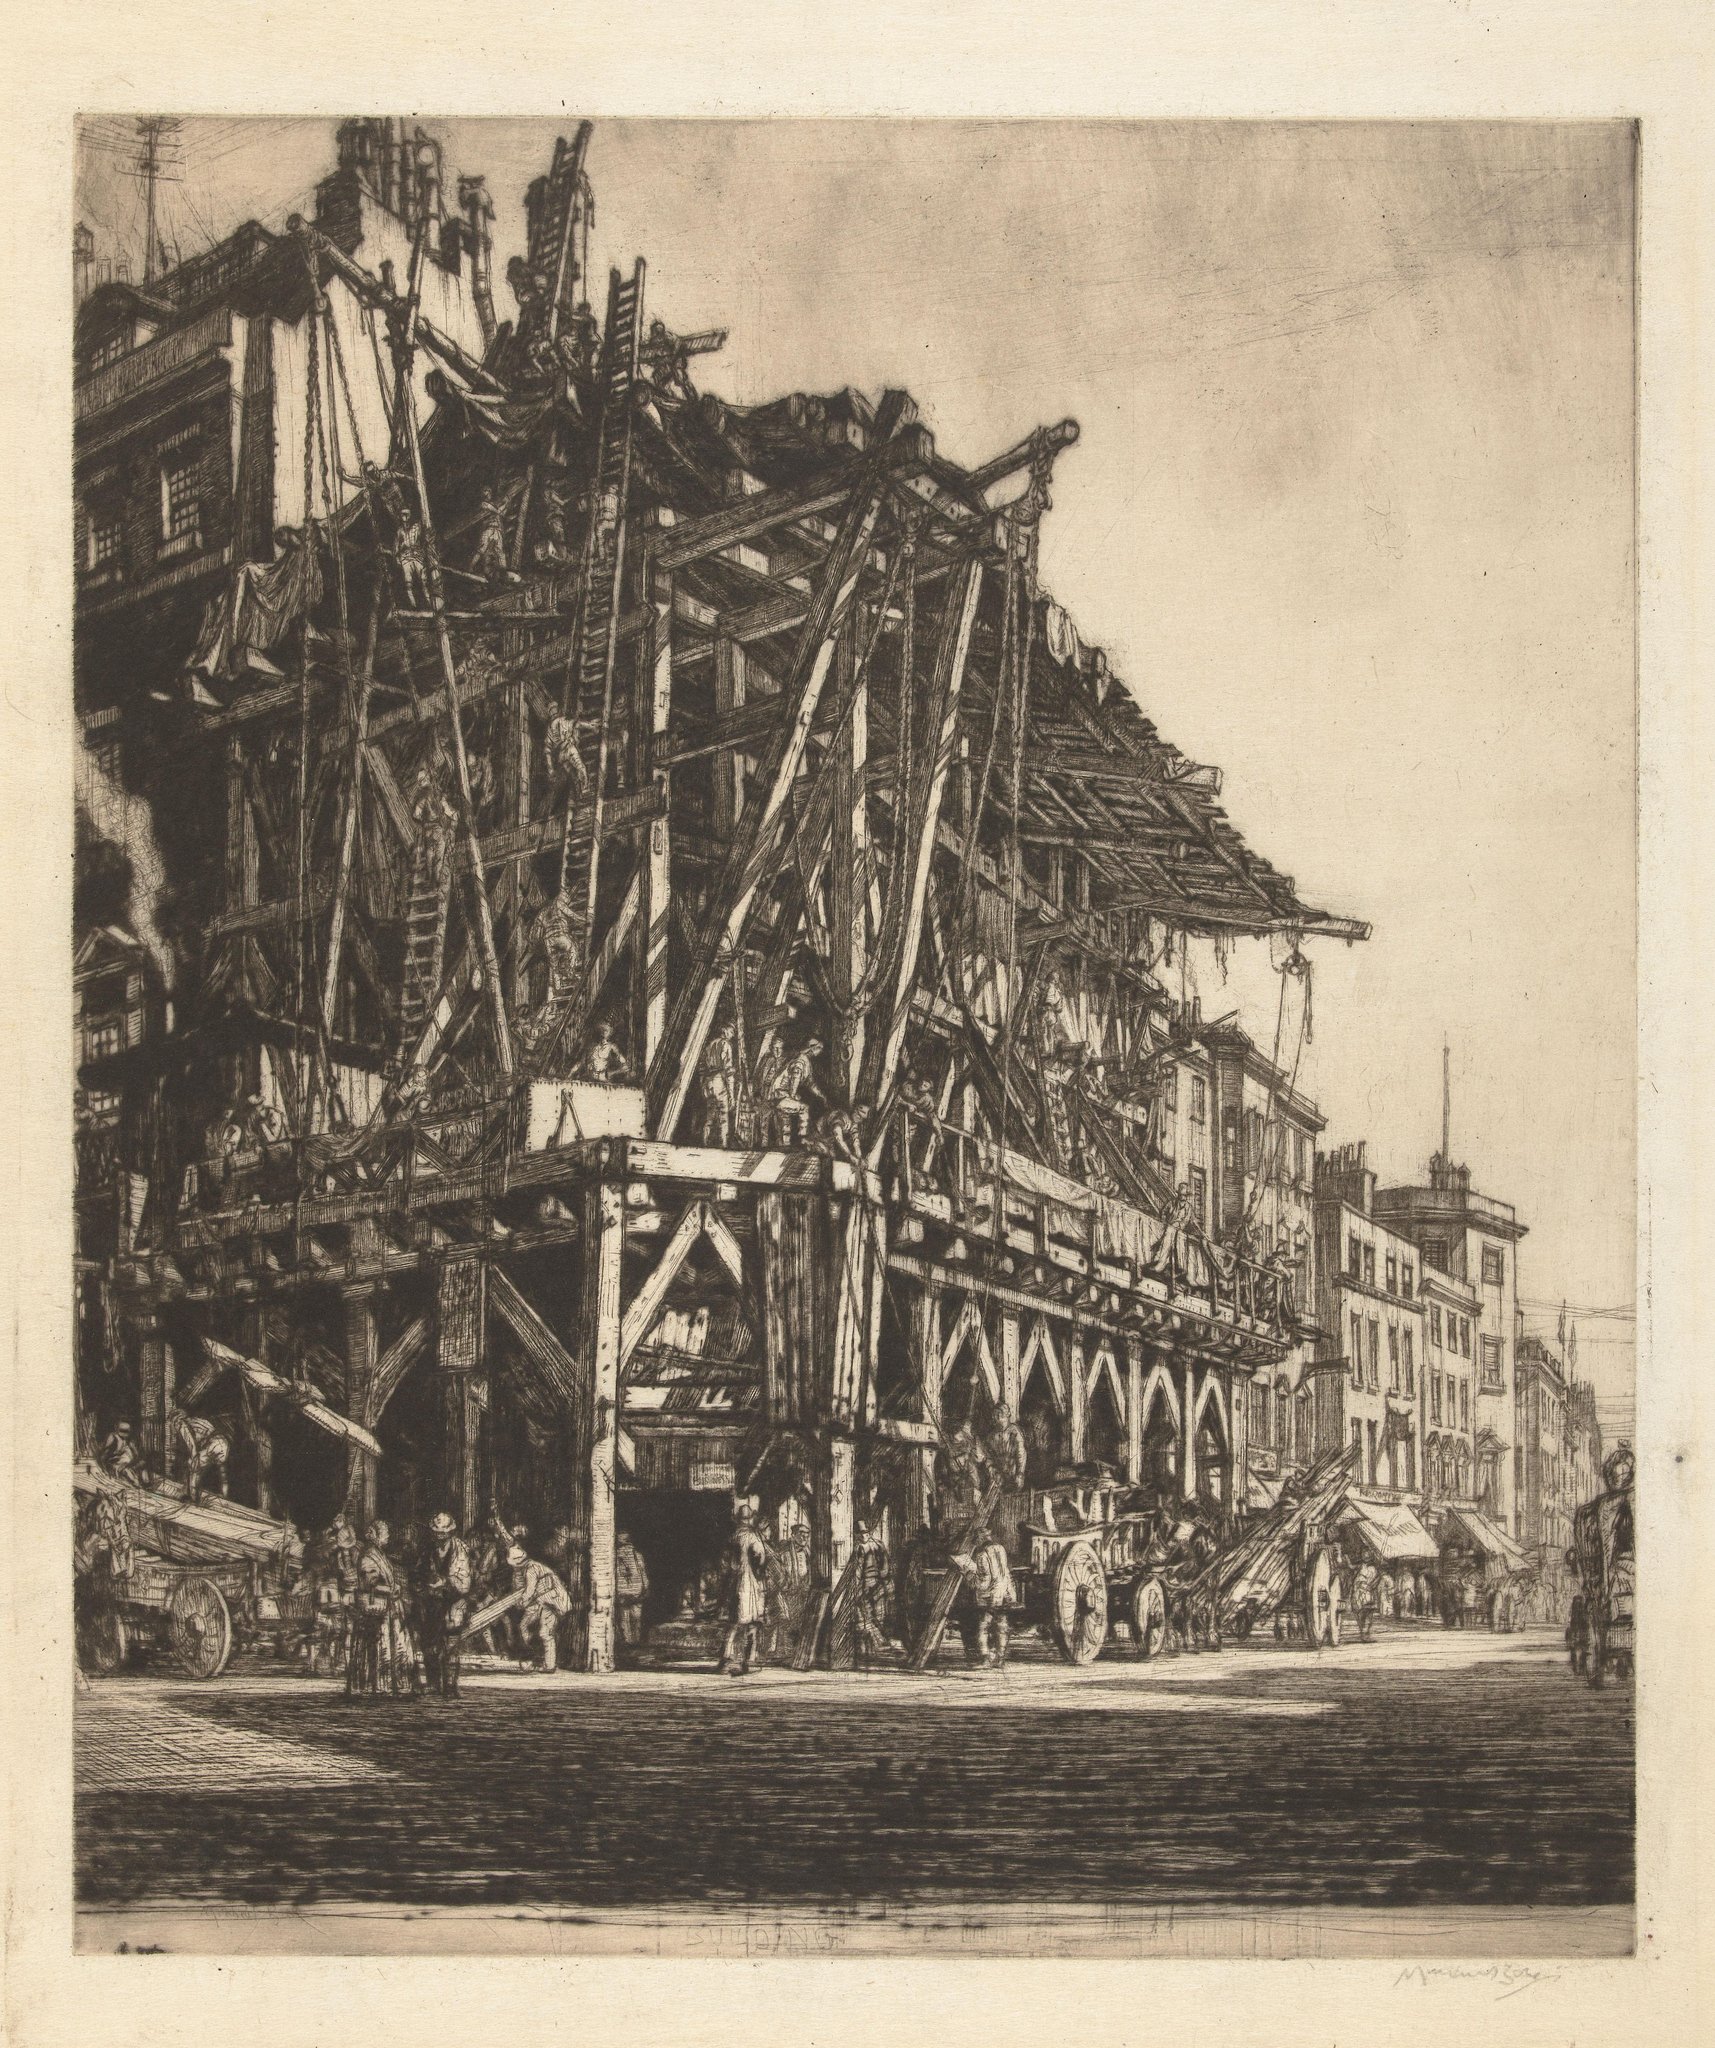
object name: print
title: De bouw van een pand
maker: muirhead bone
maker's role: artist, print maker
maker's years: 1876-1953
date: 1904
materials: paper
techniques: drypoint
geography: england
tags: building-site, london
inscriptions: signature: ‘Muirhead Bone.’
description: Op de hoek van New Bond Street nr.110 en Brook Street in Londen wordt, in de zomer van 1904, een nieuw huis gebouwd. De werklieden zijn bezig op het dak en op de verschillende verdiepingen. Tegen het huis staan steigers en lange ladders, hout wordt aangevoerd op karren.